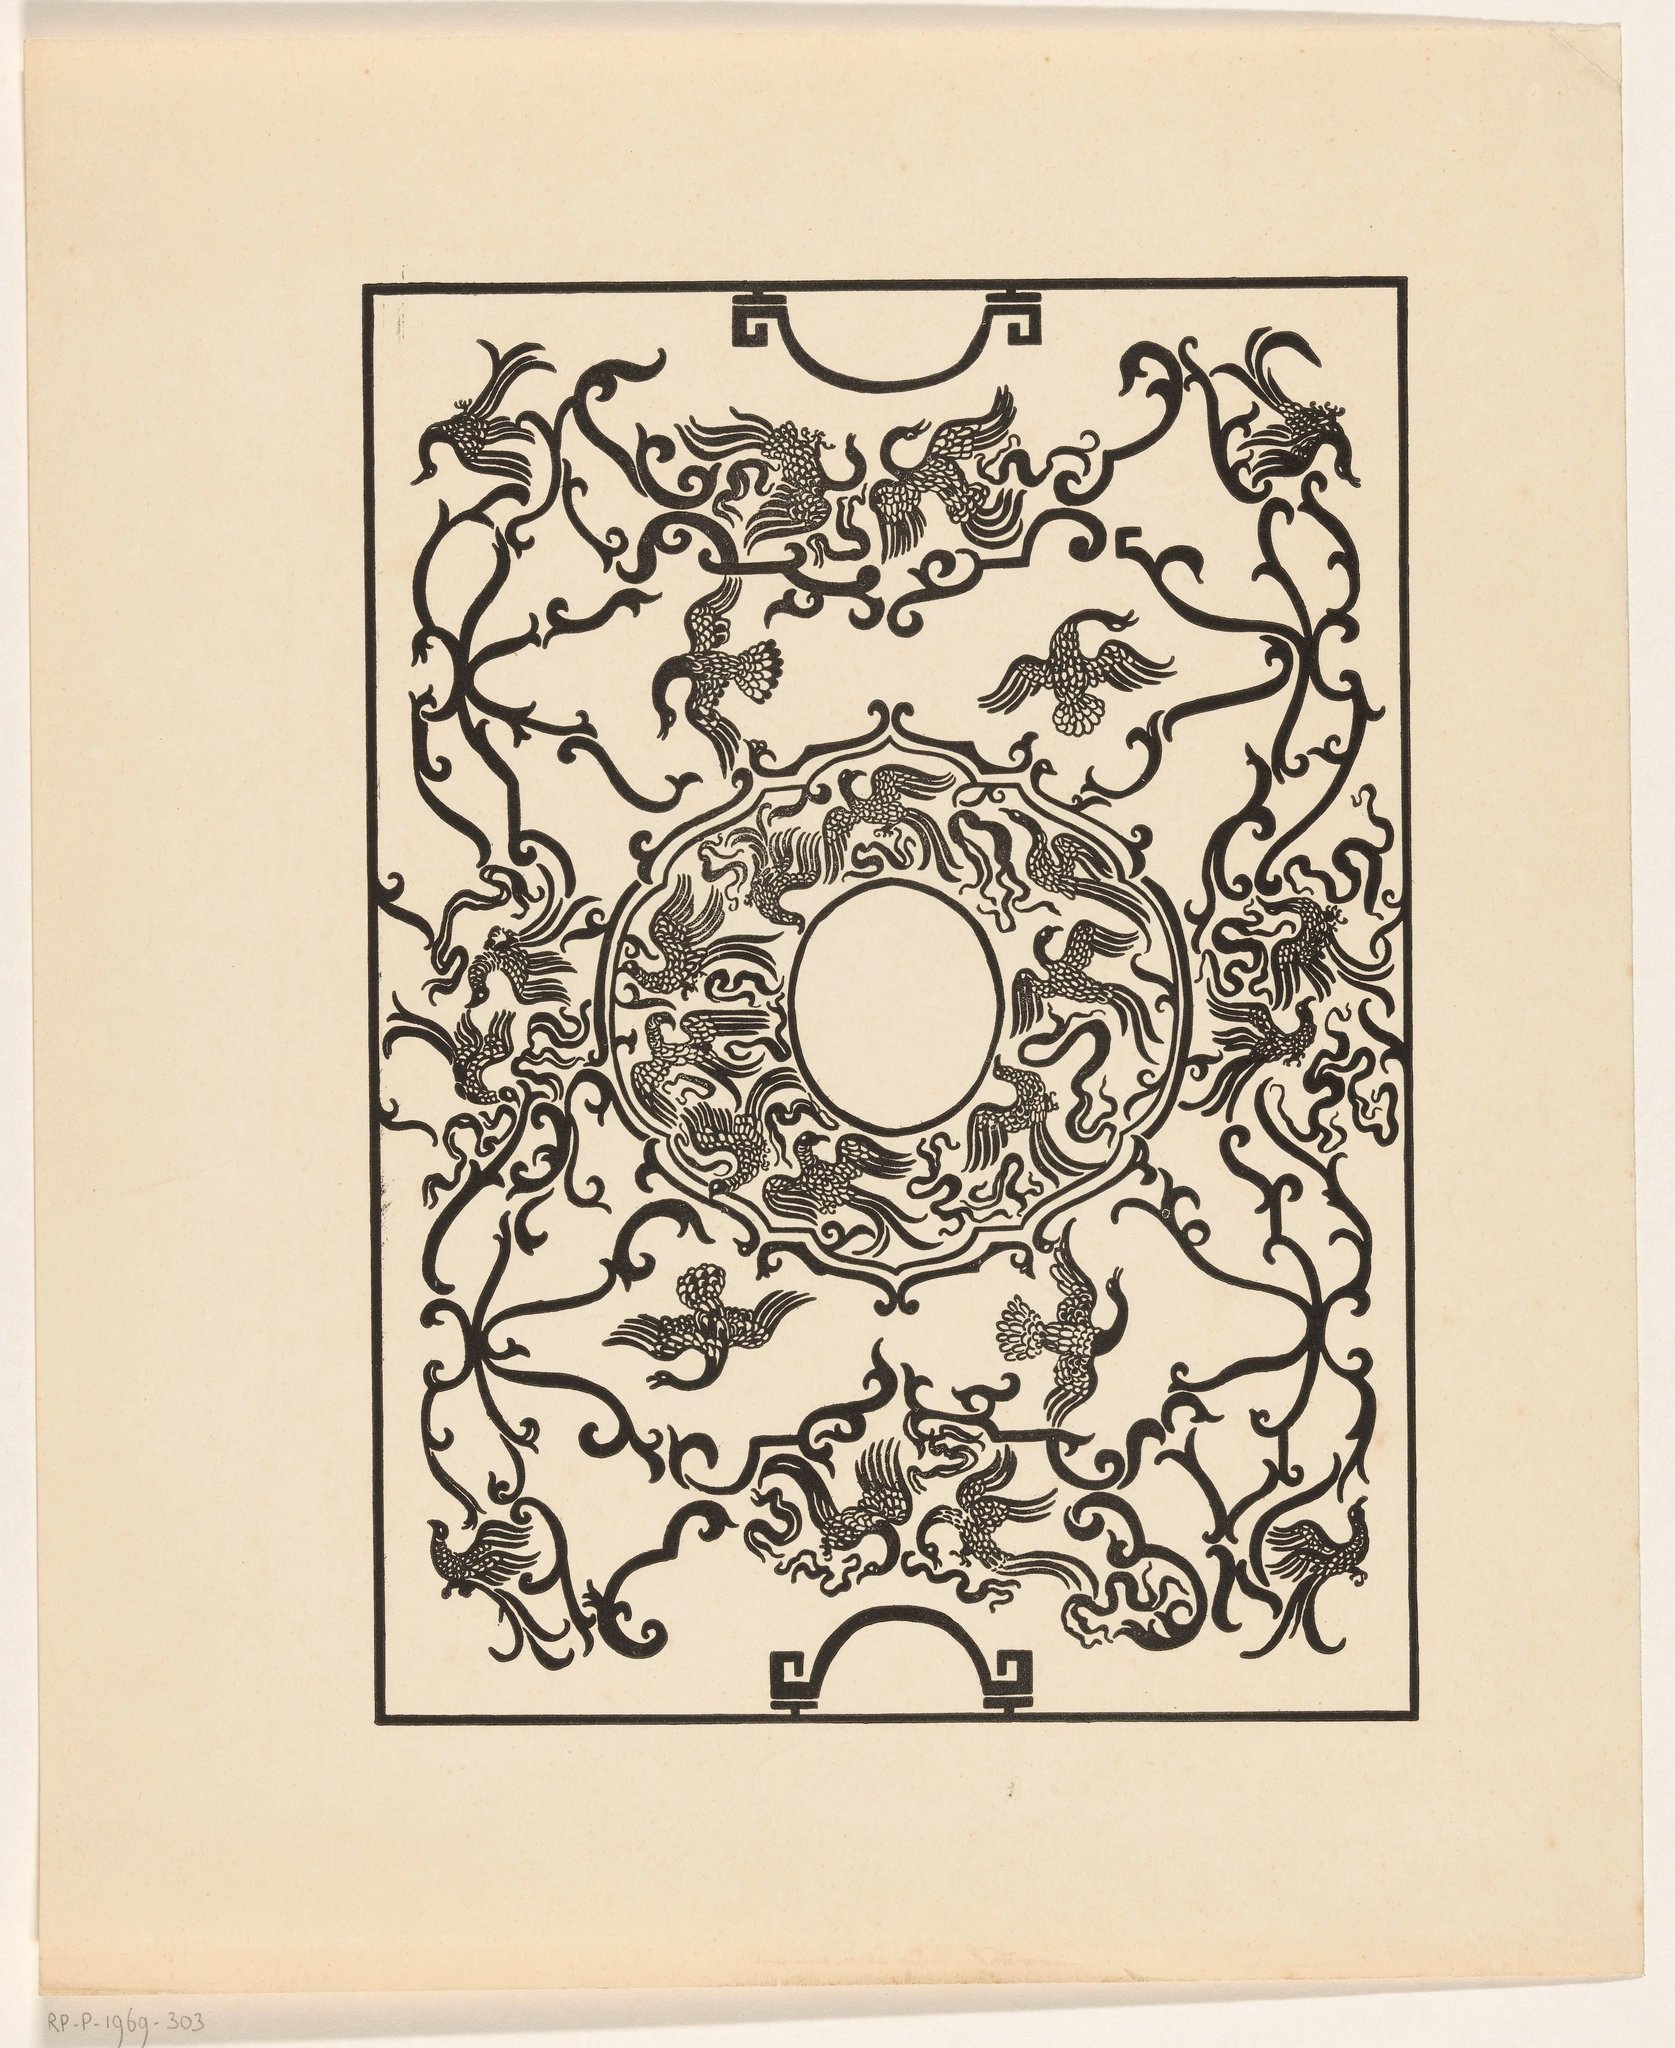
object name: print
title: Bandontwerp voor: L'art hollandais à l'exposition internationale des arts décoratifs et industriels modernes, 1925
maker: carel adolph lion cachet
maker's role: draughtsman, print maker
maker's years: 1864-1945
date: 1925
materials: paper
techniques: printing block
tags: ornament derived from animal forms, birds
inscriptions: collector's mark: Lugt 2228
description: Prent mogelijk gebruikt voor: L'art hollandais à l'exposition internationale des arts décoratifs et industriels modernes. Haarlem: Enschedé & Zonen, 1925.